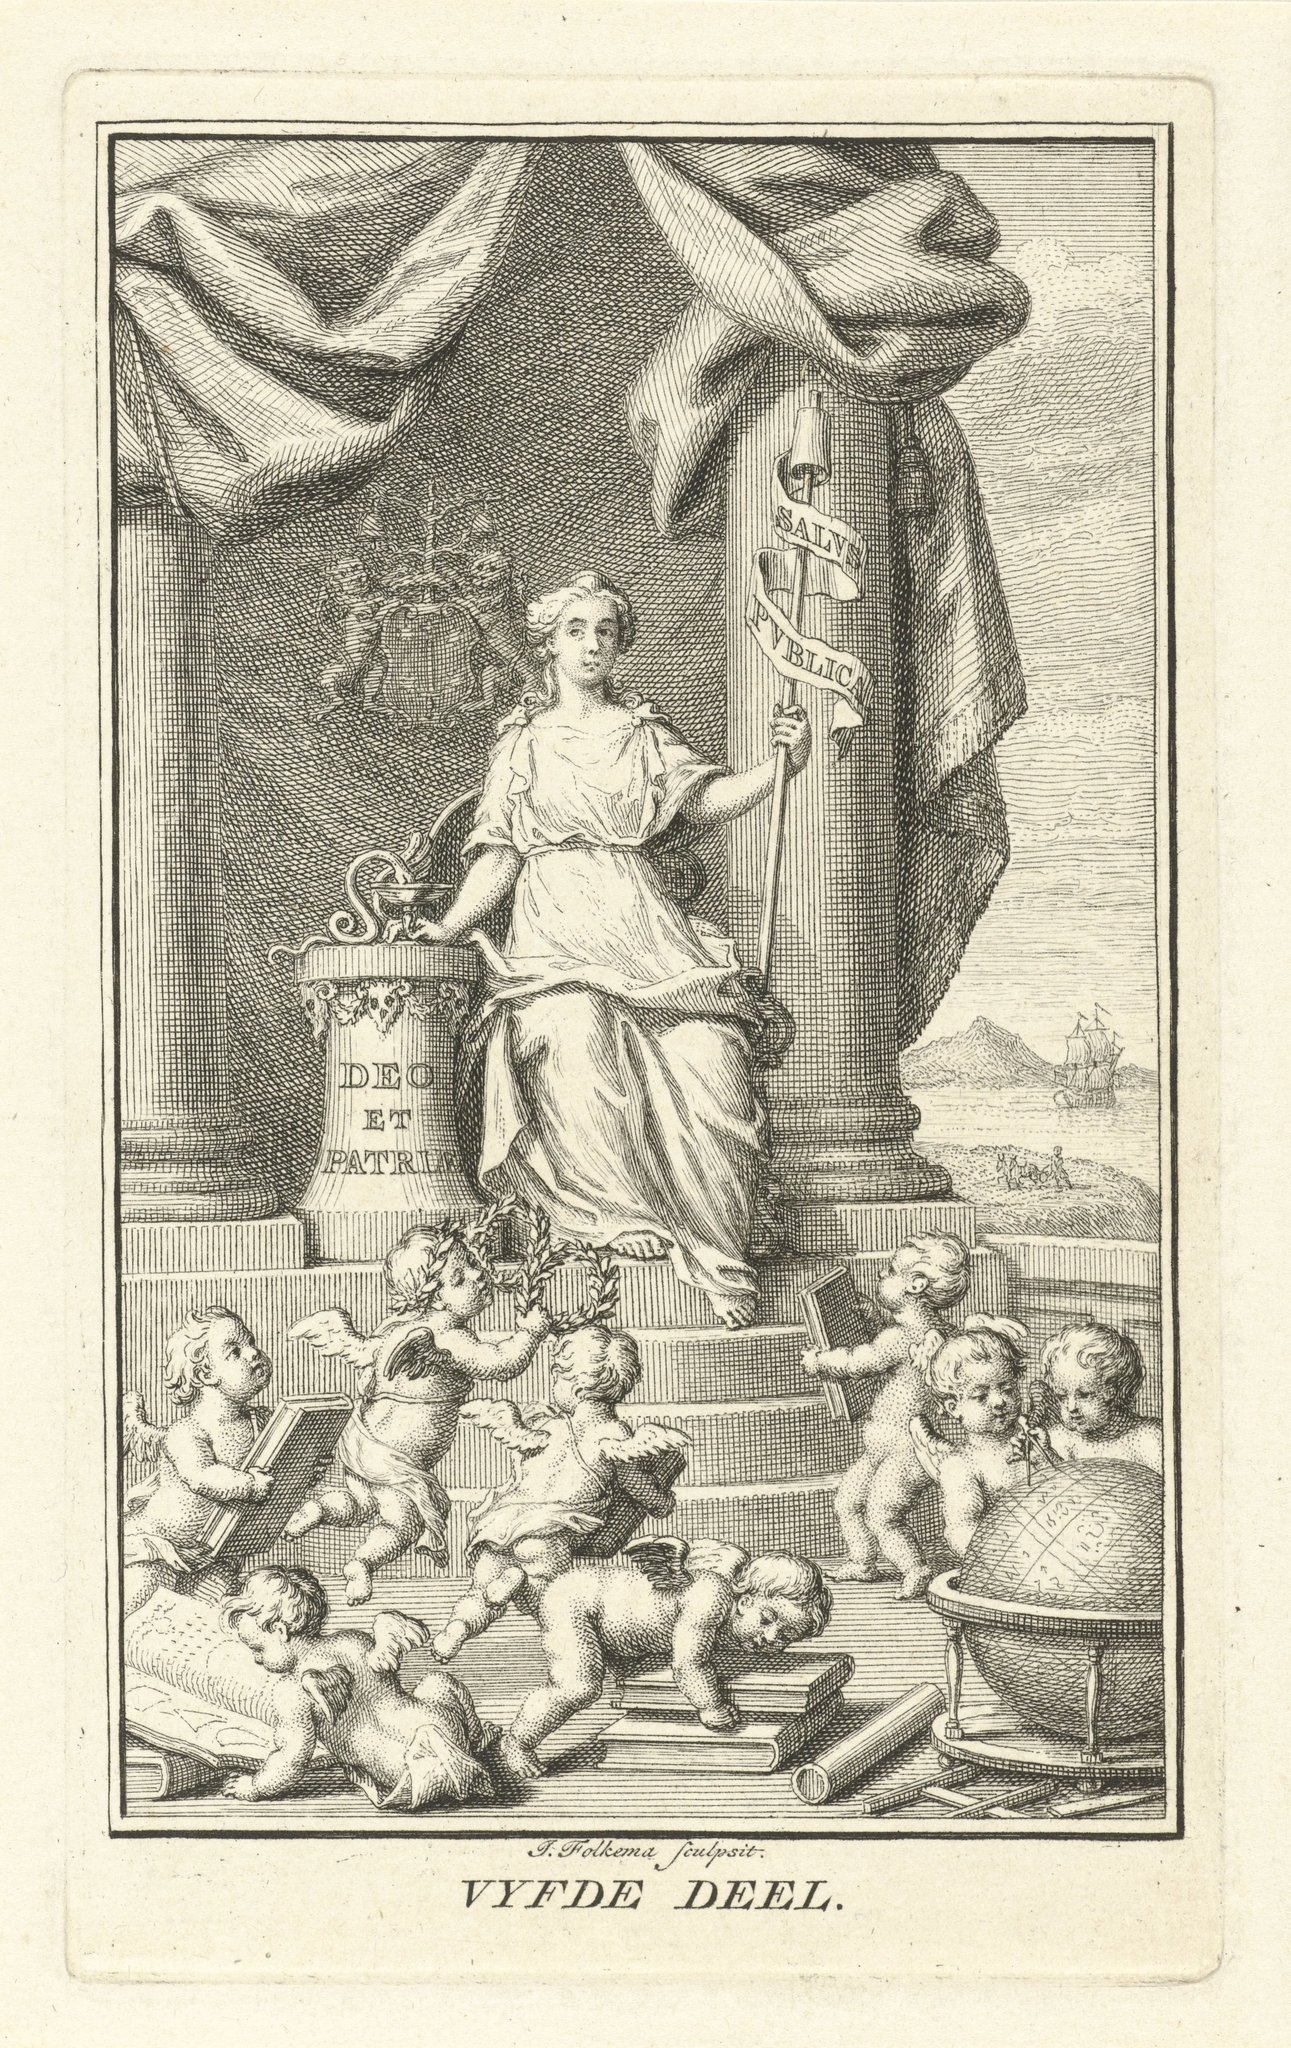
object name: print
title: Tronende vrijheidsmaagd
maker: jacob folkema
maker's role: draughtsman, print maker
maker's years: 1692-1767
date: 1702-1767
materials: paper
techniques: etching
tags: freedom, liberty; 'libertà' (ripa), cupids: 'amores', 'amoretti', 'putti'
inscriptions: collector's mark: Lugt 240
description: De vrijheidsmaagd zit naast een offerzuil op een verhoging. In haar hand houdt ze een lans met vrijheidshoed. Op de voorgrond spelen putti met boeken en een wereldbol.